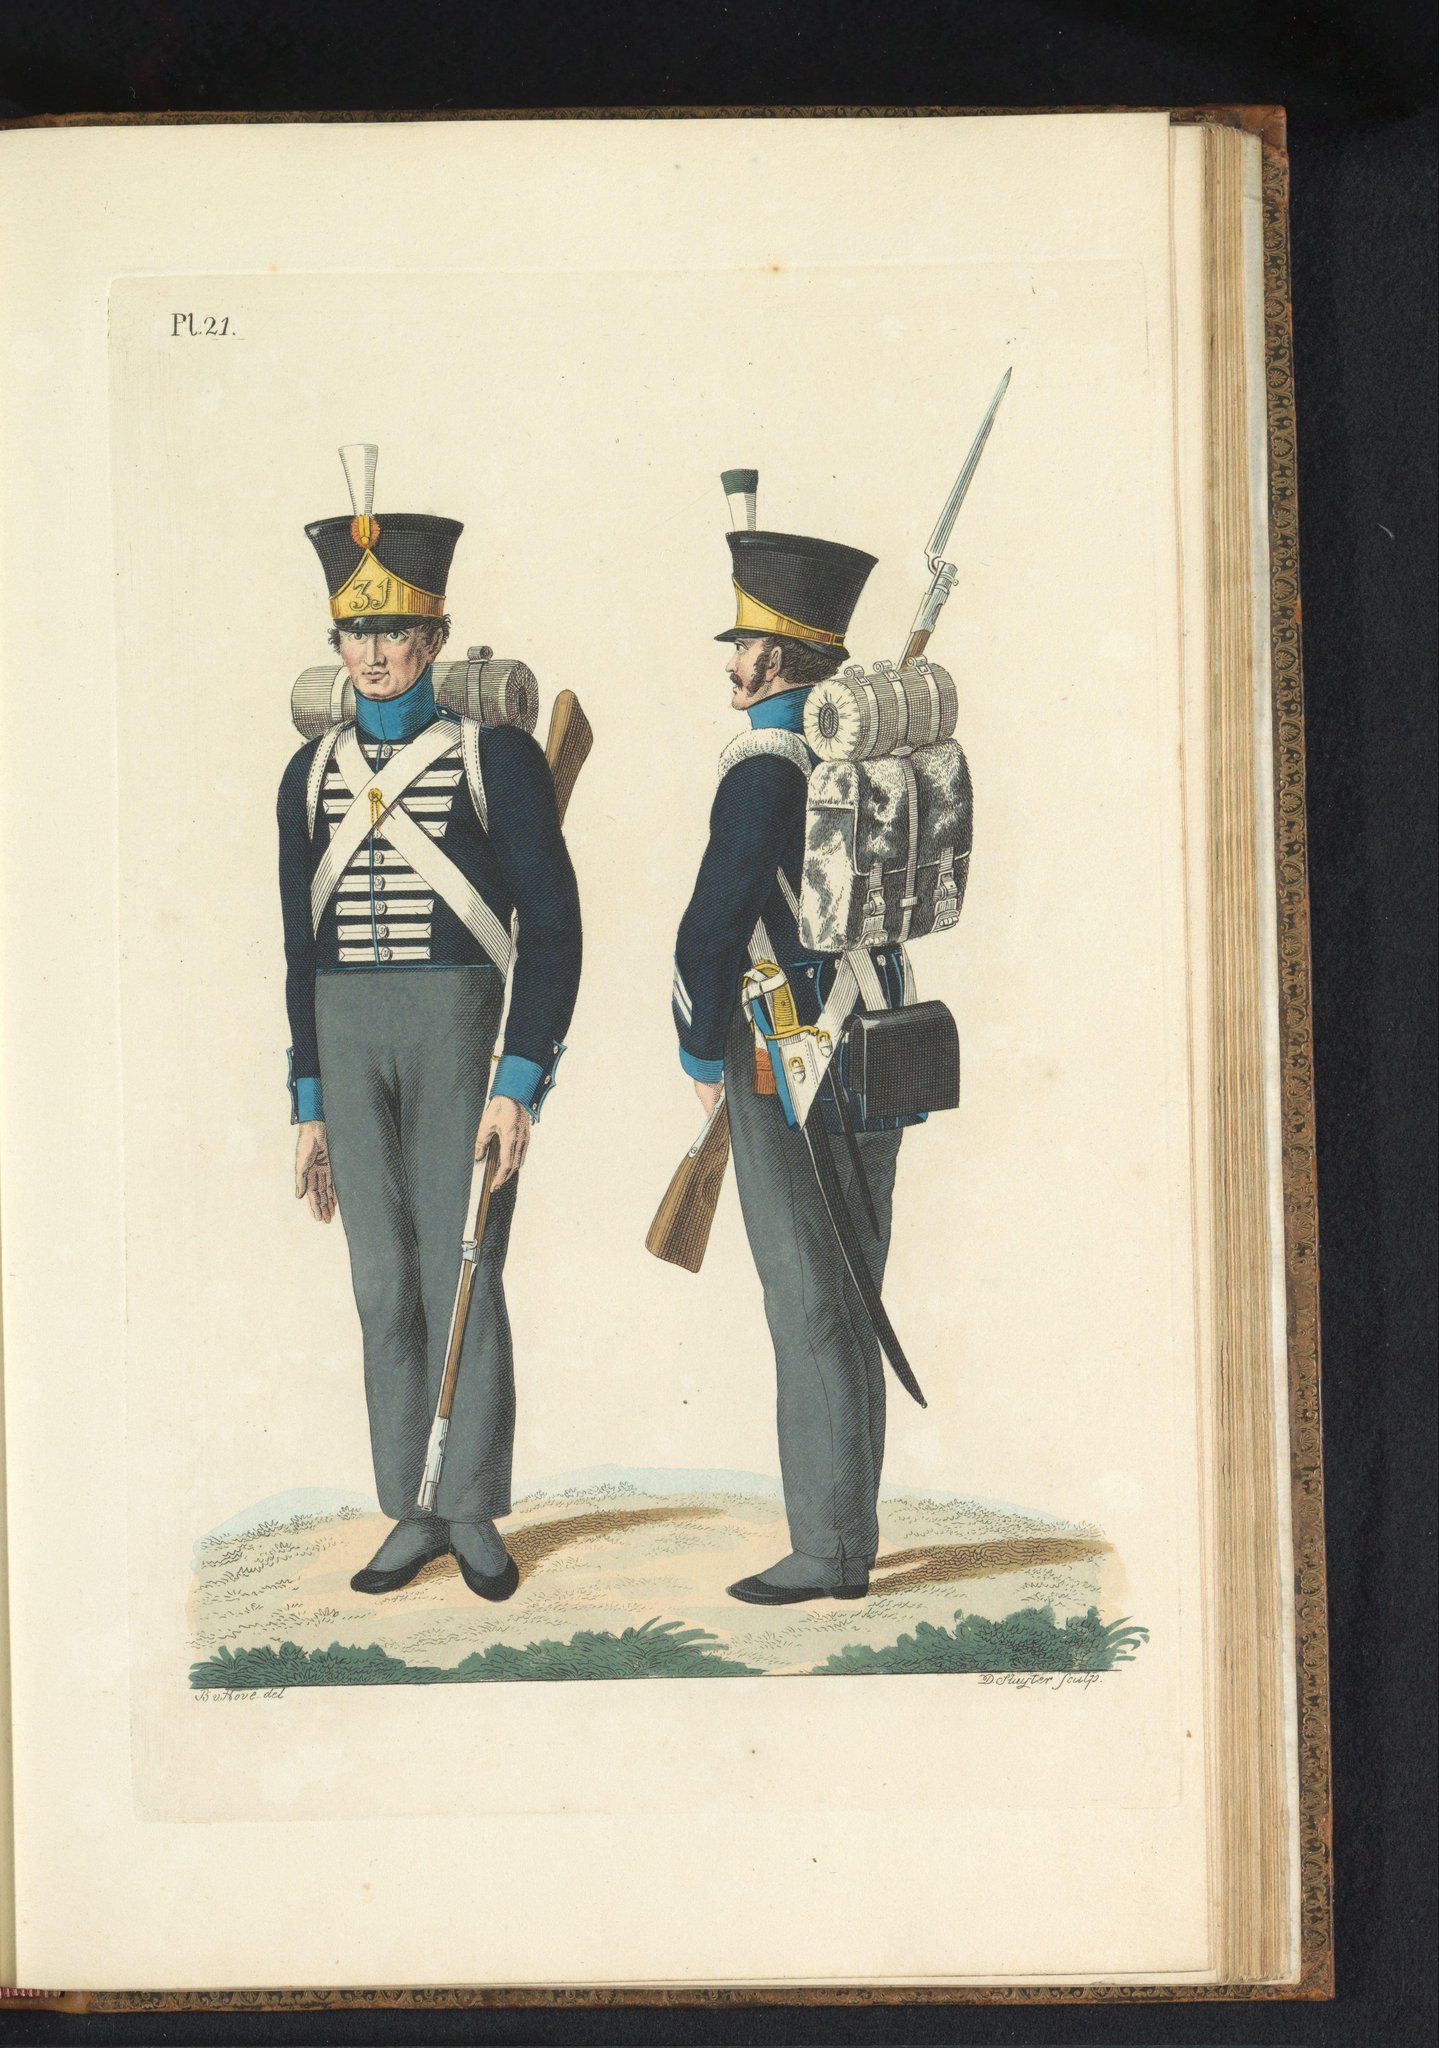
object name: print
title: Flankeur en Fuselier van het Regiment Zwitsers no. 31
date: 1823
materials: paper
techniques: engraving, etching, hand coloring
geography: netherlands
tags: (military) uniforms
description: Een flankeur en fuselier van het Regiment Zwitsers no. 31. Plaat 21. Uniformvoorstelling in 'Beschrijving hoedanig de Koninklijke Nederlandsche troepen' van J.F. Teupken, 1823.